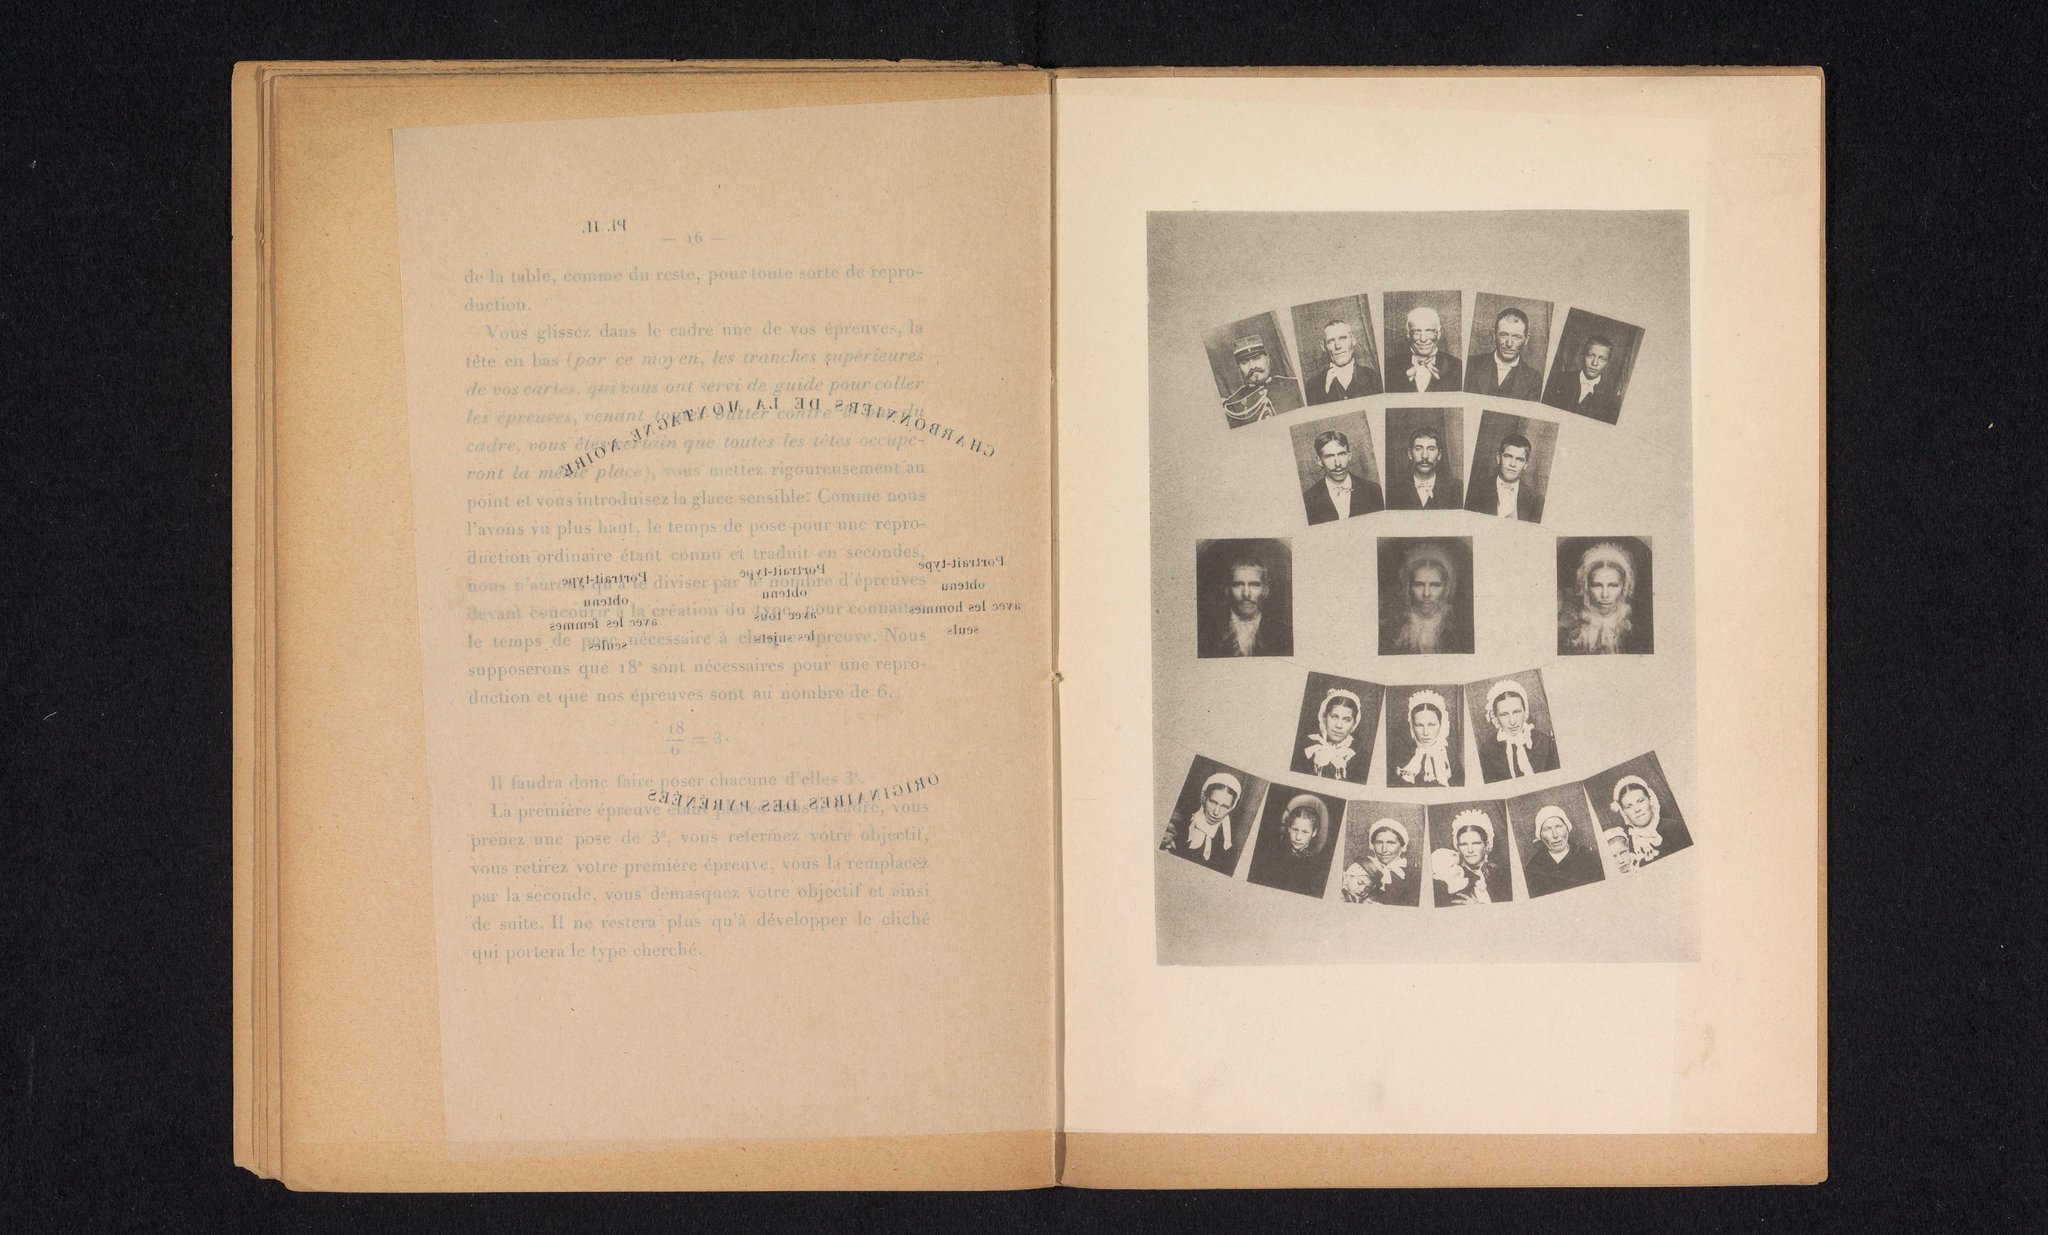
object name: page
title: Zeventien portretten van inwoners rond de Montagne Noire, met in het midden drie superimposities van deze portretten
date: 1877-1887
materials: paper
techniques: photograph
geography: midi-pyrenees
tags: human types, anonymous historical person portrayed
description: Linksmidden een superimpositie van enkel de mannen, midden een superimpositie van alle portretten, rechtsmidden een superimpositie van enkel de vrouwen.